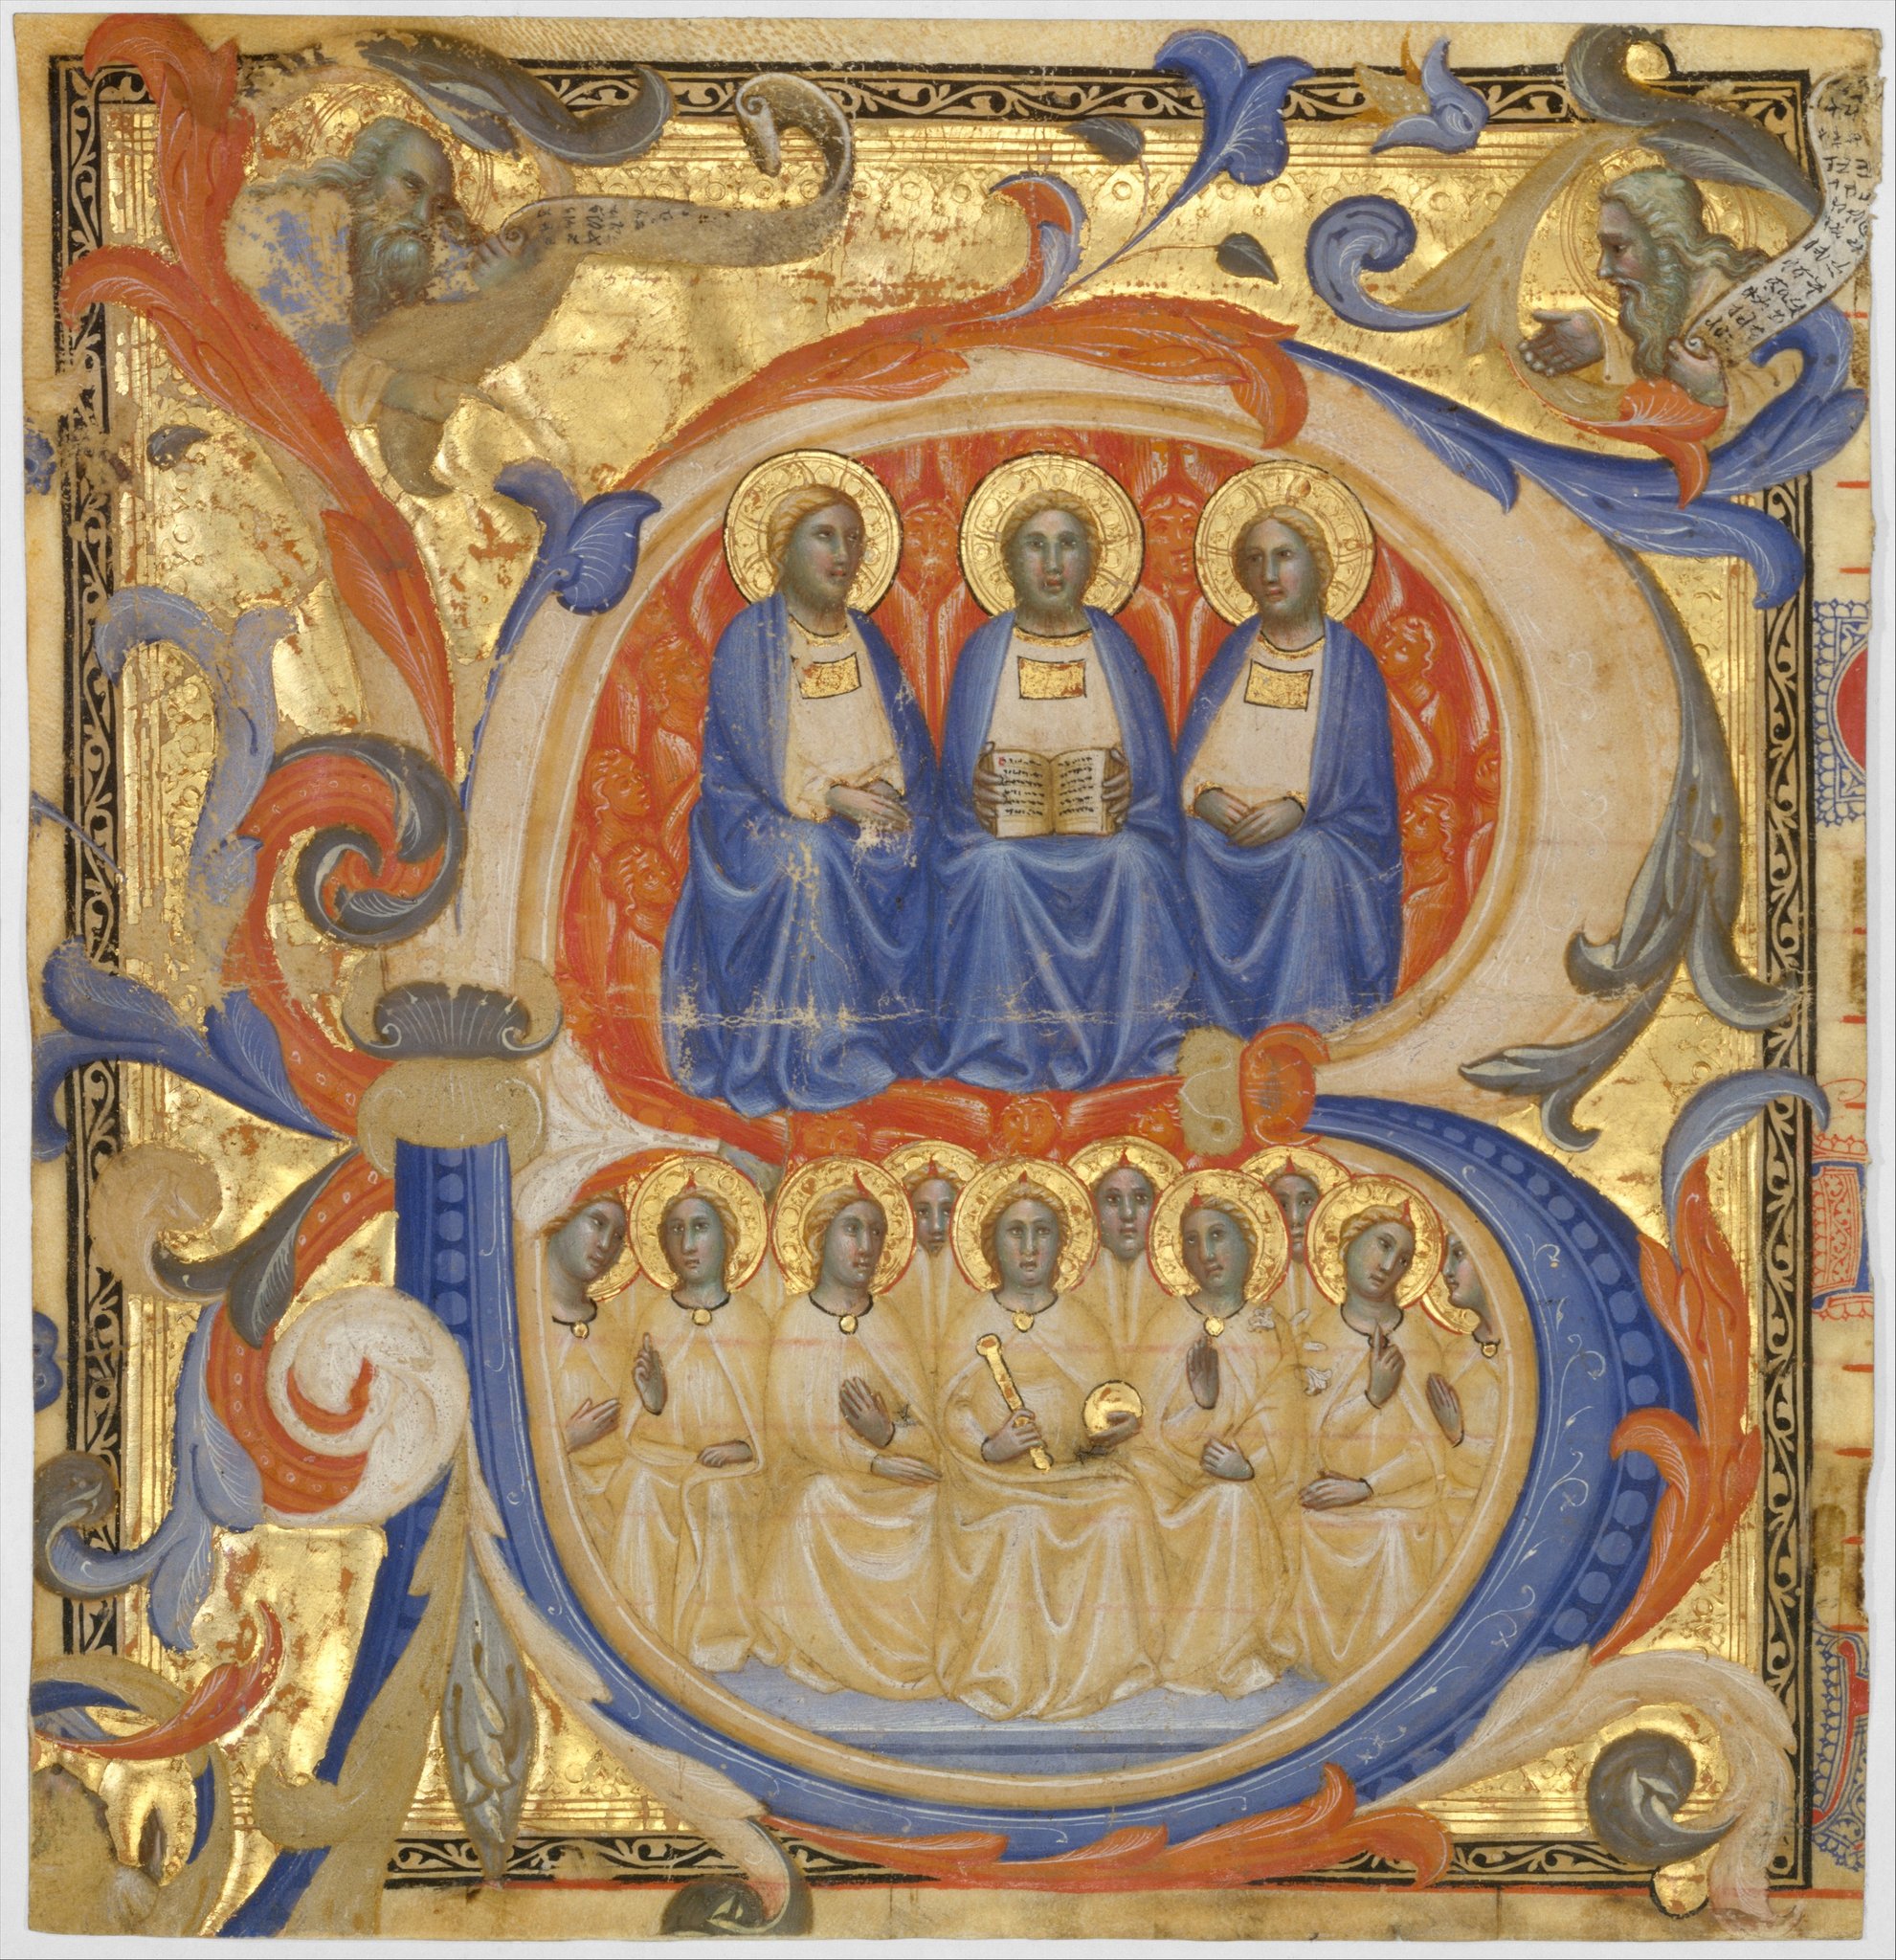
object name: cutting from a gradual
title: The Trinity in an Initial B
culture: italian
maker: master of the codex rossiano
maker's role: artist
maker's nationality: sienese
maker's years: 1380-1400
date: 1387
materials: gold, parchment, paint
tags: angels